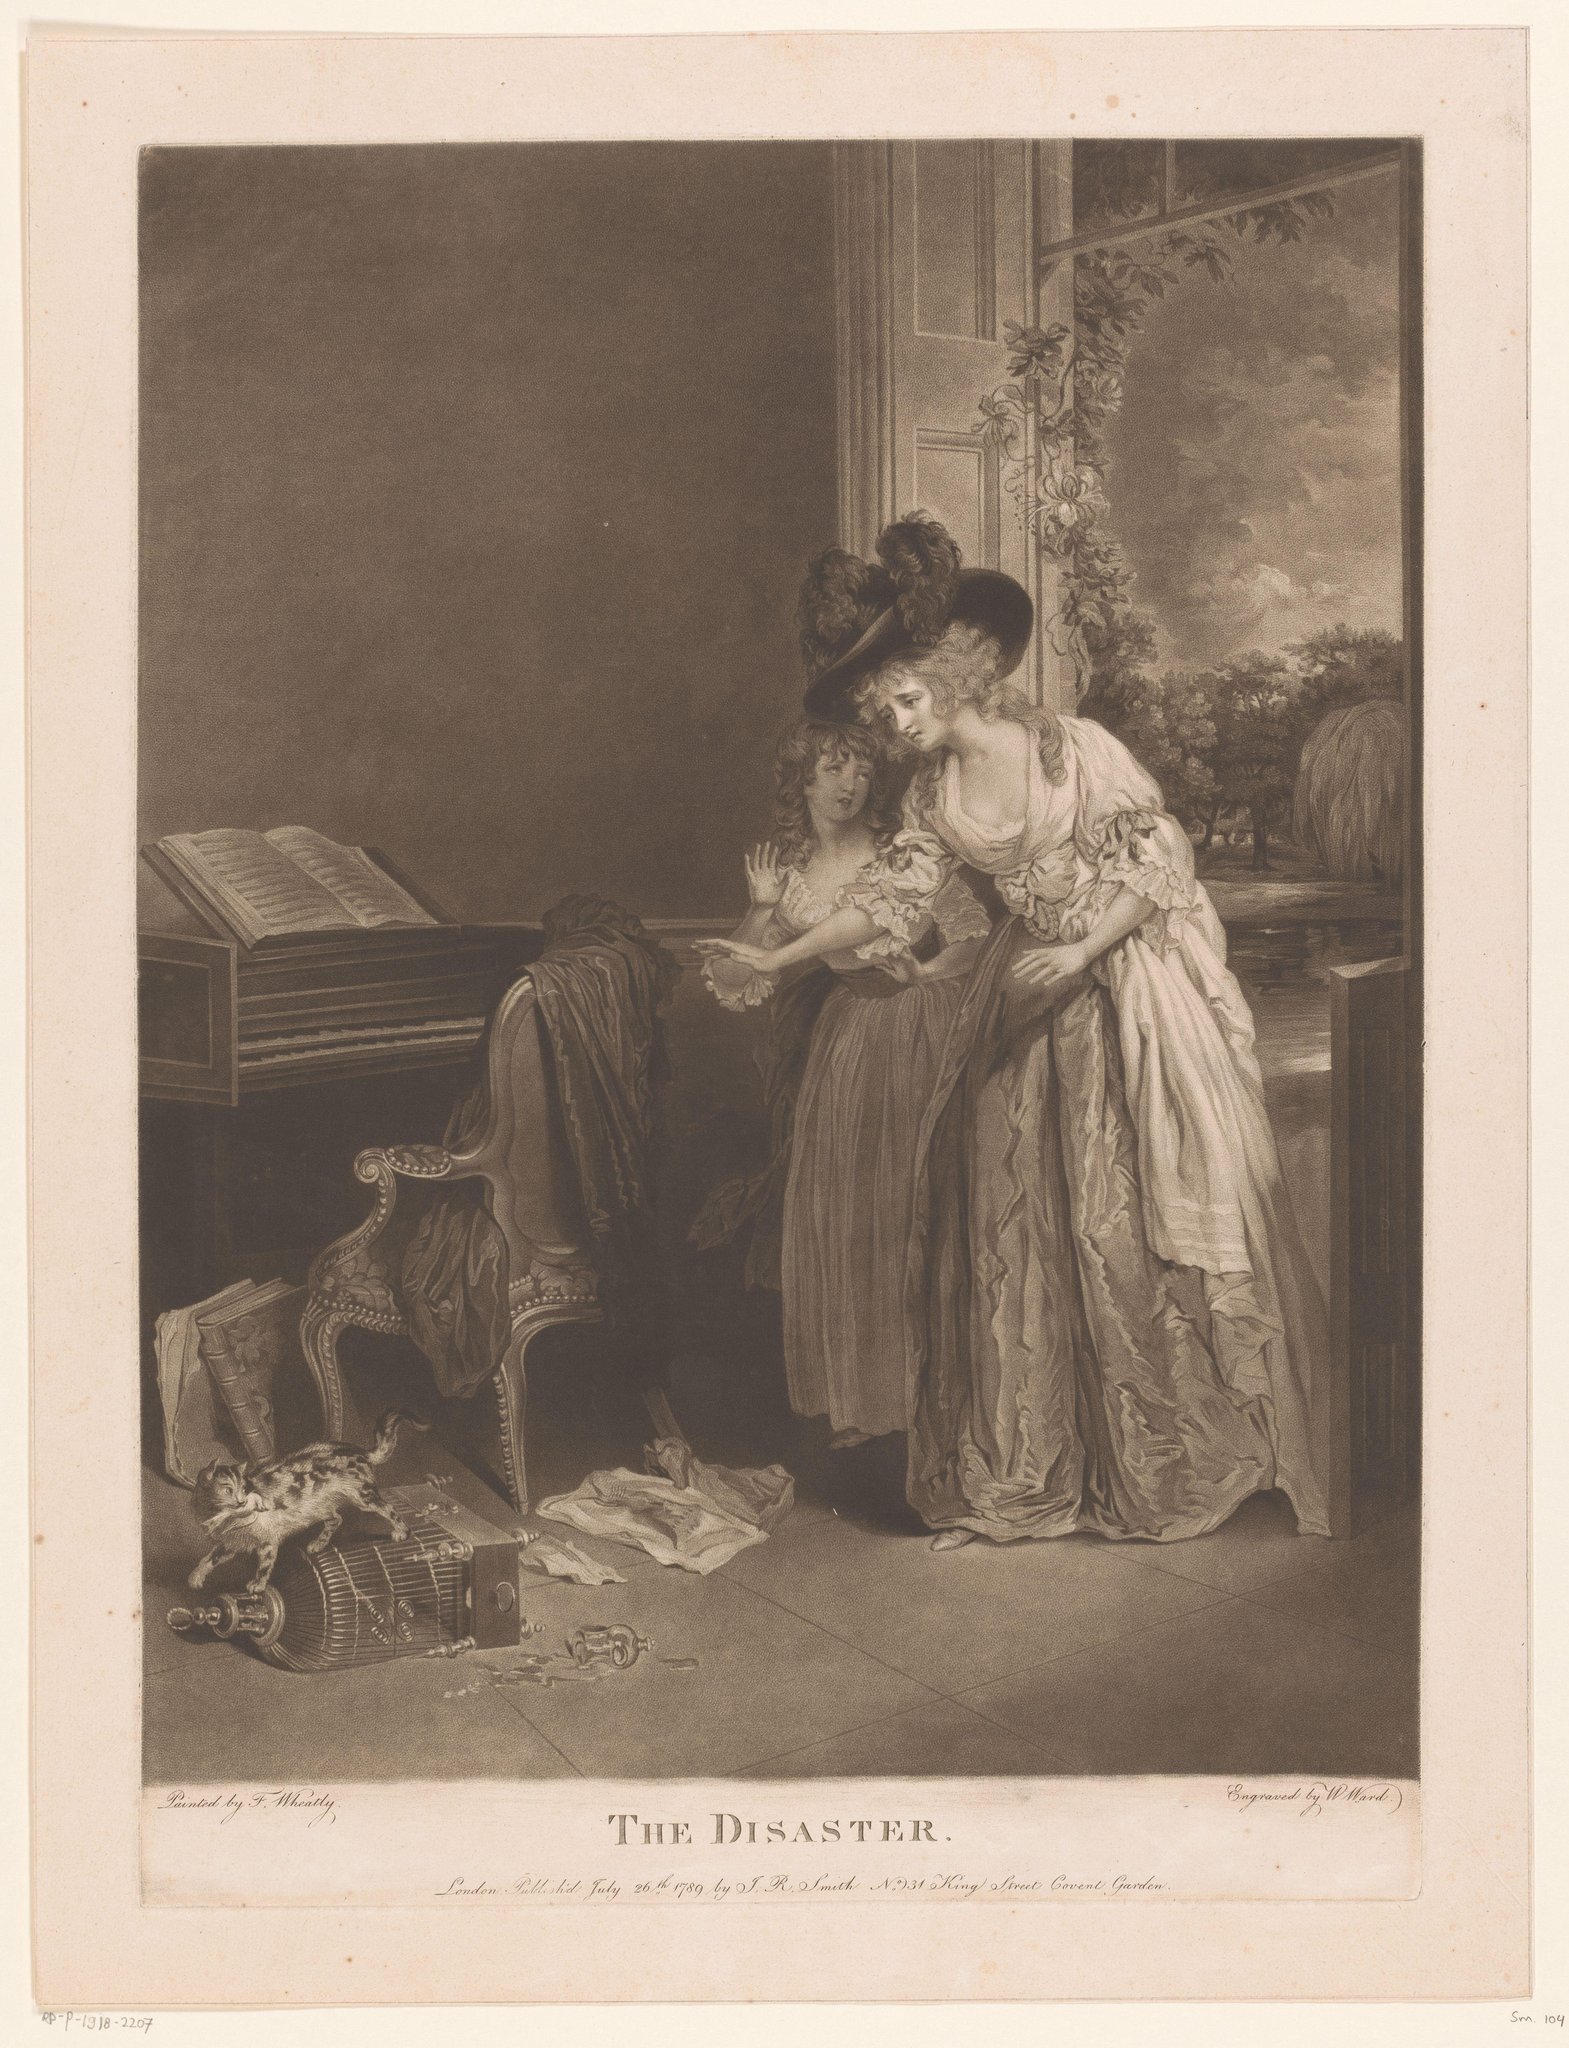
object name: print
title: The Disaster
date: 1789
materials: paper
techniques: mezzotint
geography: london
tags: empty bird cage, cat, domestic birds (inside the house)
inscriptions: collector's mark: Lugt 2233